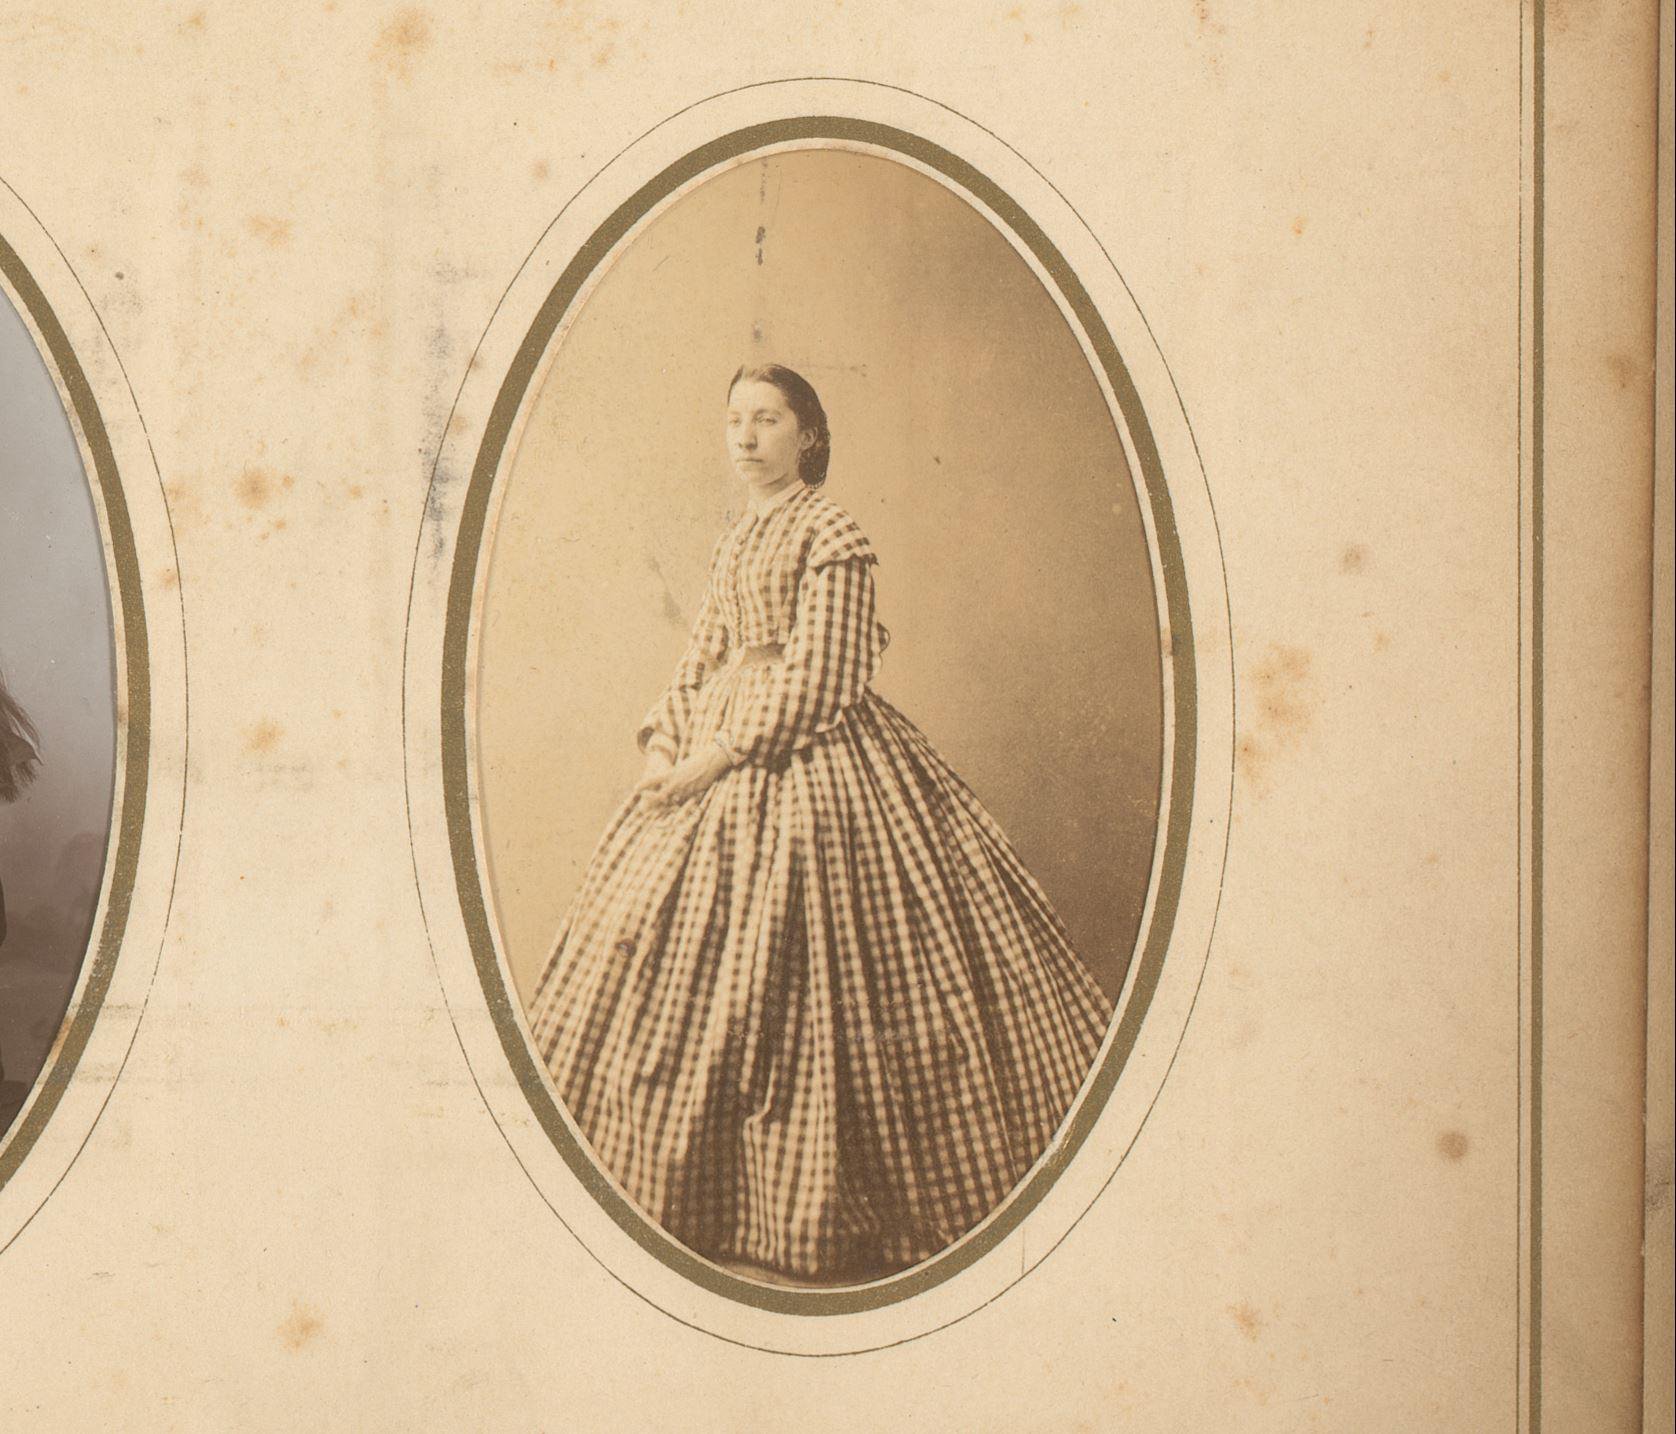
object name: carte de visite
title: Portret van een staande vrouw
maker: Anonymous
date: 1860-1900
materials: cardboard, photographic support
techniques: albumen print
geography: netherlands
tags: historical persons - bb - woman, standing figure - aa - female human figure